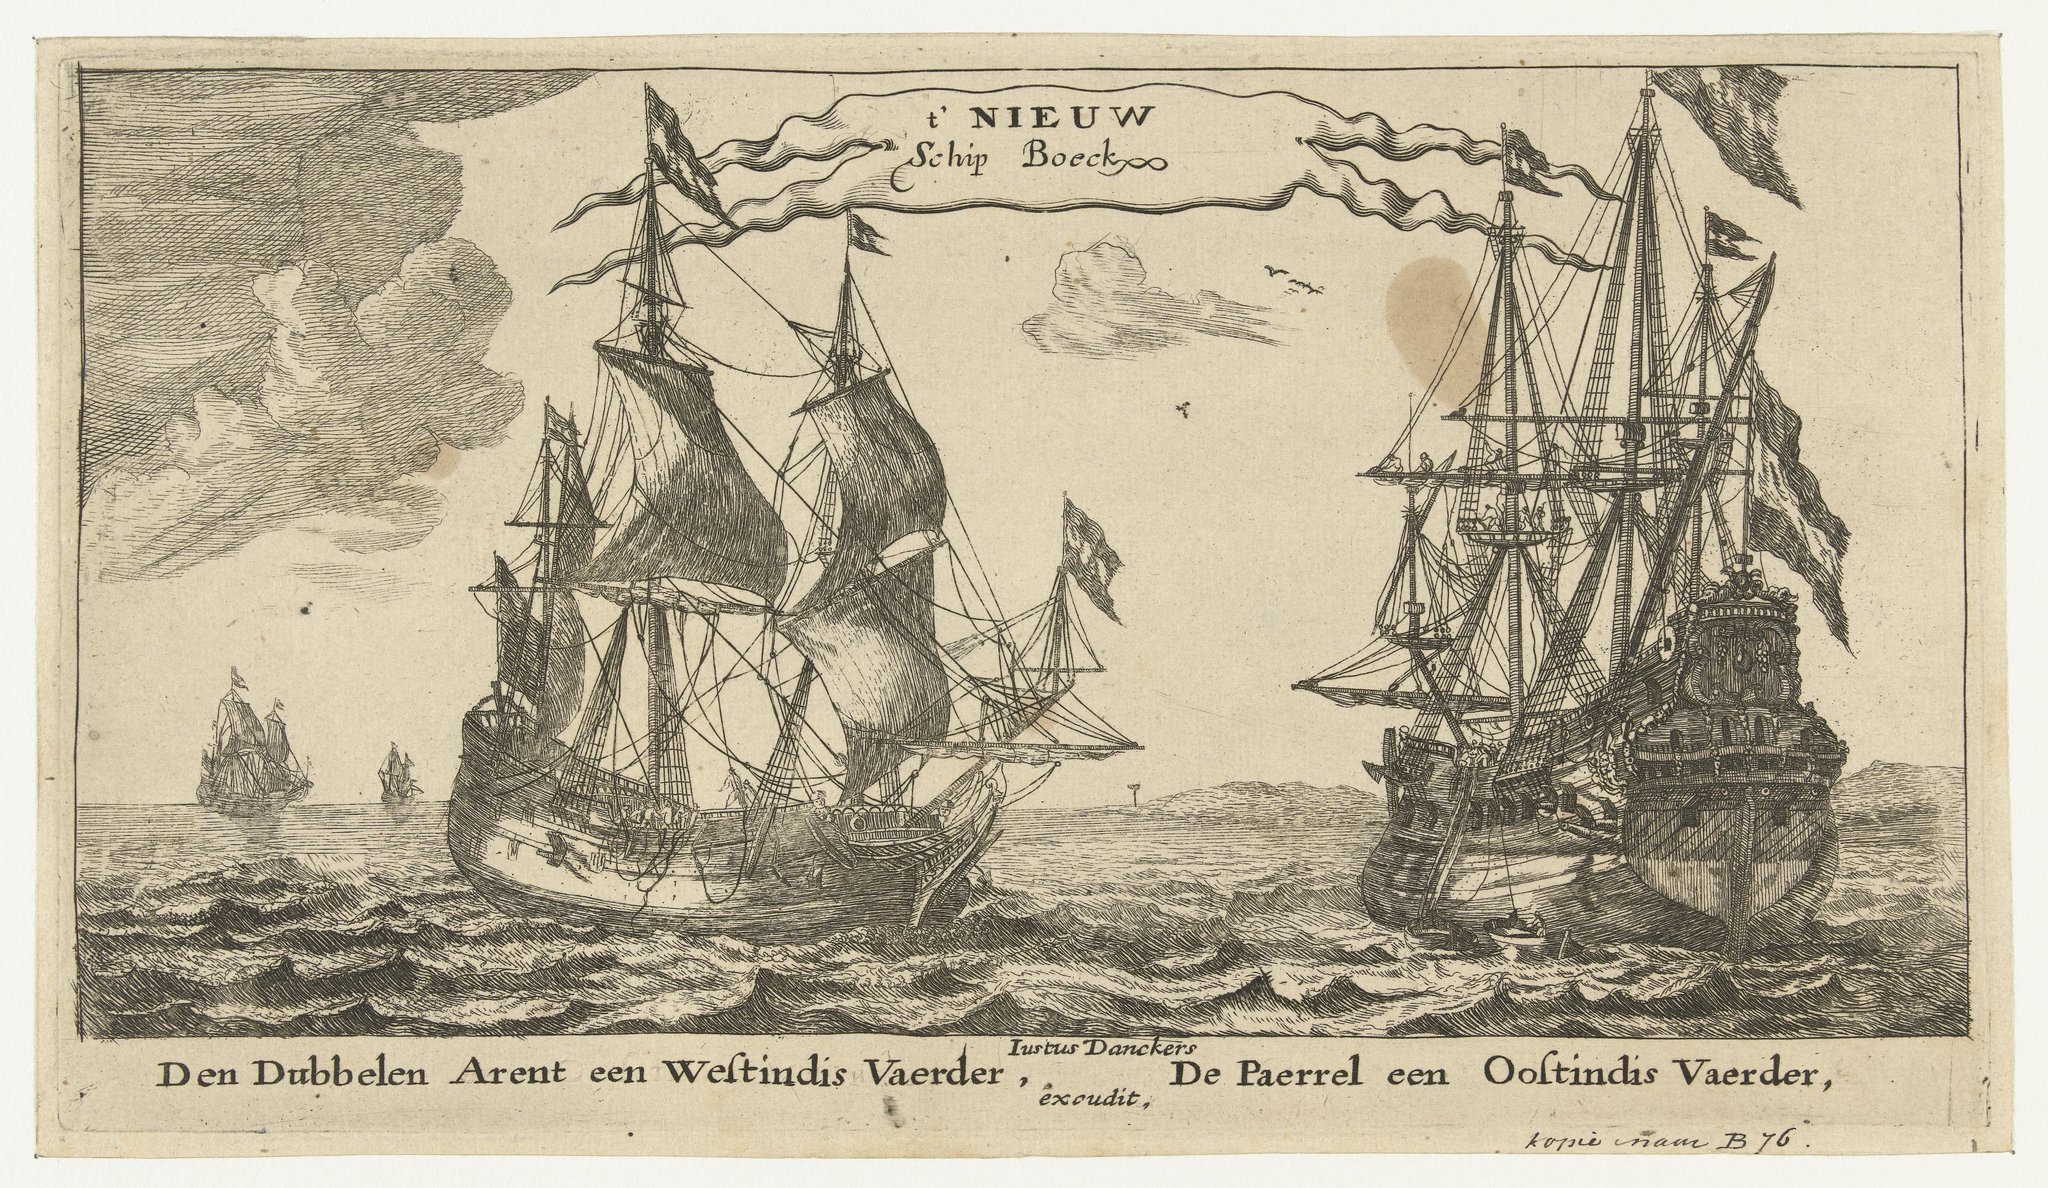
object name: titelprent, frontispice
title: t' Nieuw Schip Boeck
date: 1652-1701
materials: paper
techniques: etching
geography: netherlands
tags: sailing-ship, sailing-boat (eastindiaman), sailing-ship, sailing-boat (westindiaman)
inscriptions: inscription: ‘kopie naar B76’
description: Kopie in spiegelbeeld. Titelblad van "t' Nieuw Schip Boeck", met twee koopvaardijschepen op zee vlak bij land. Rechts De Parel, een Oost-indiëvaarder en links De Dubbele Arend, een West-indiëvaarder.